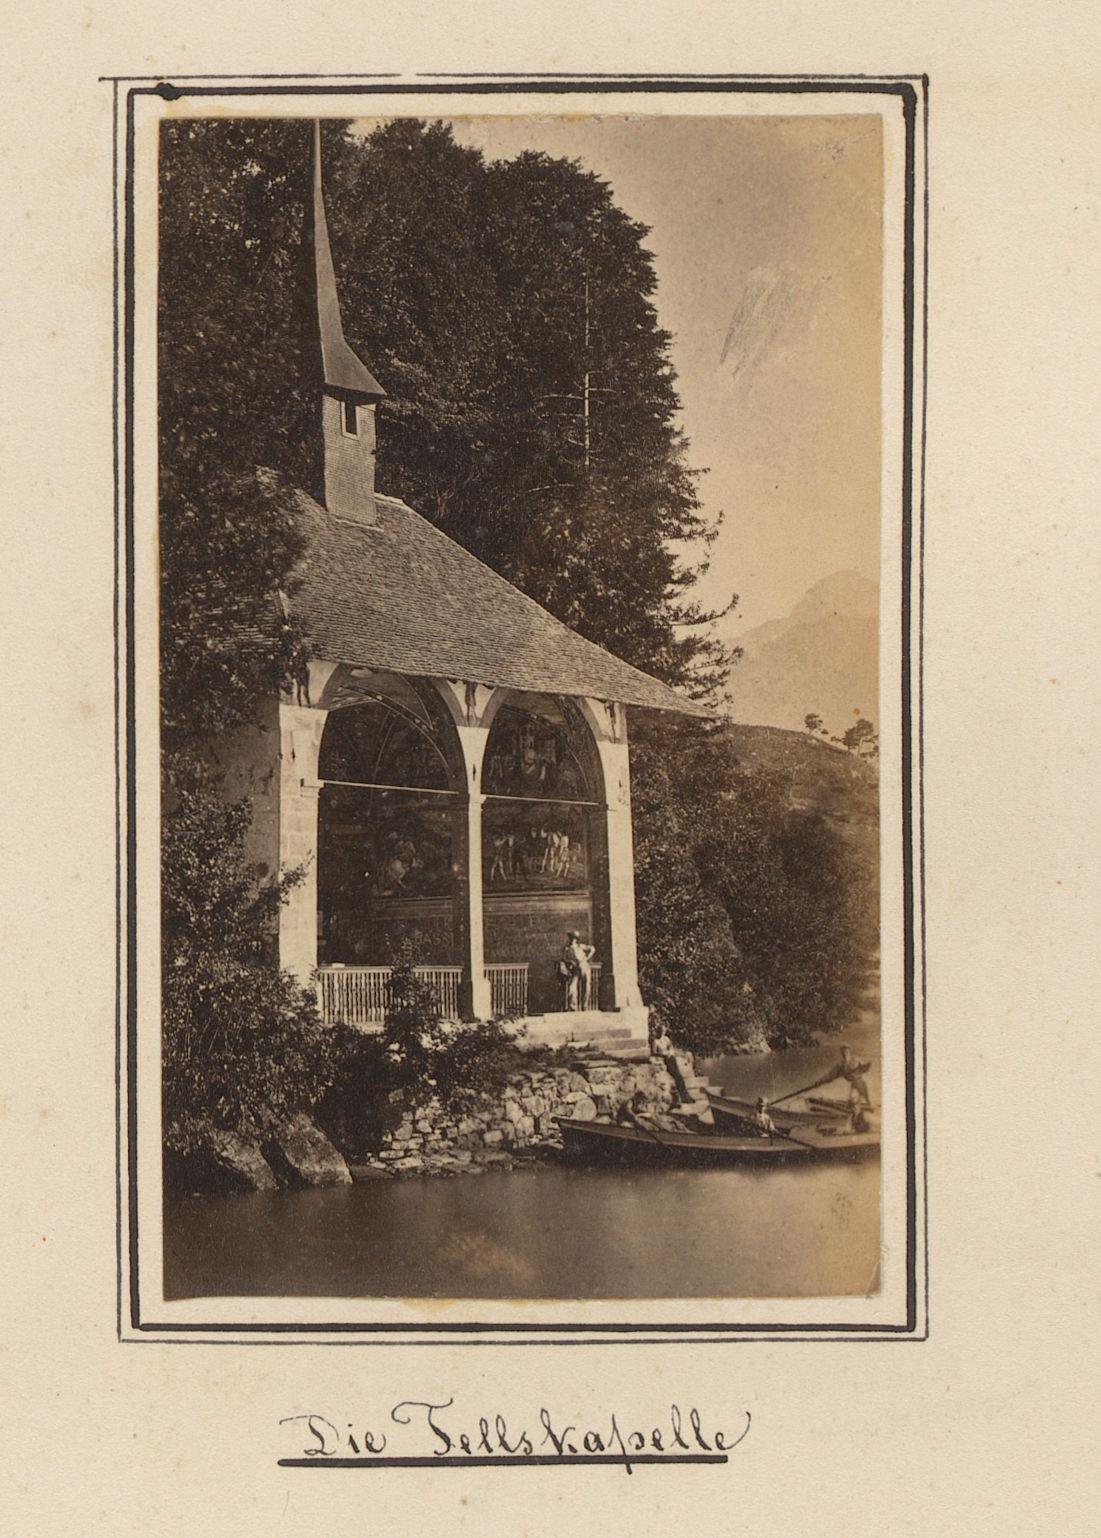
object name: album leaf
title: Kapel van Wilhelm Tell aan het Vierwoudstrekenmeer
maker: Anonymous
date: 1870-1879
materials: paper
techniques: albumen print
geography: tellskapelle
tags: church (exterior) - qq - small church, chapel